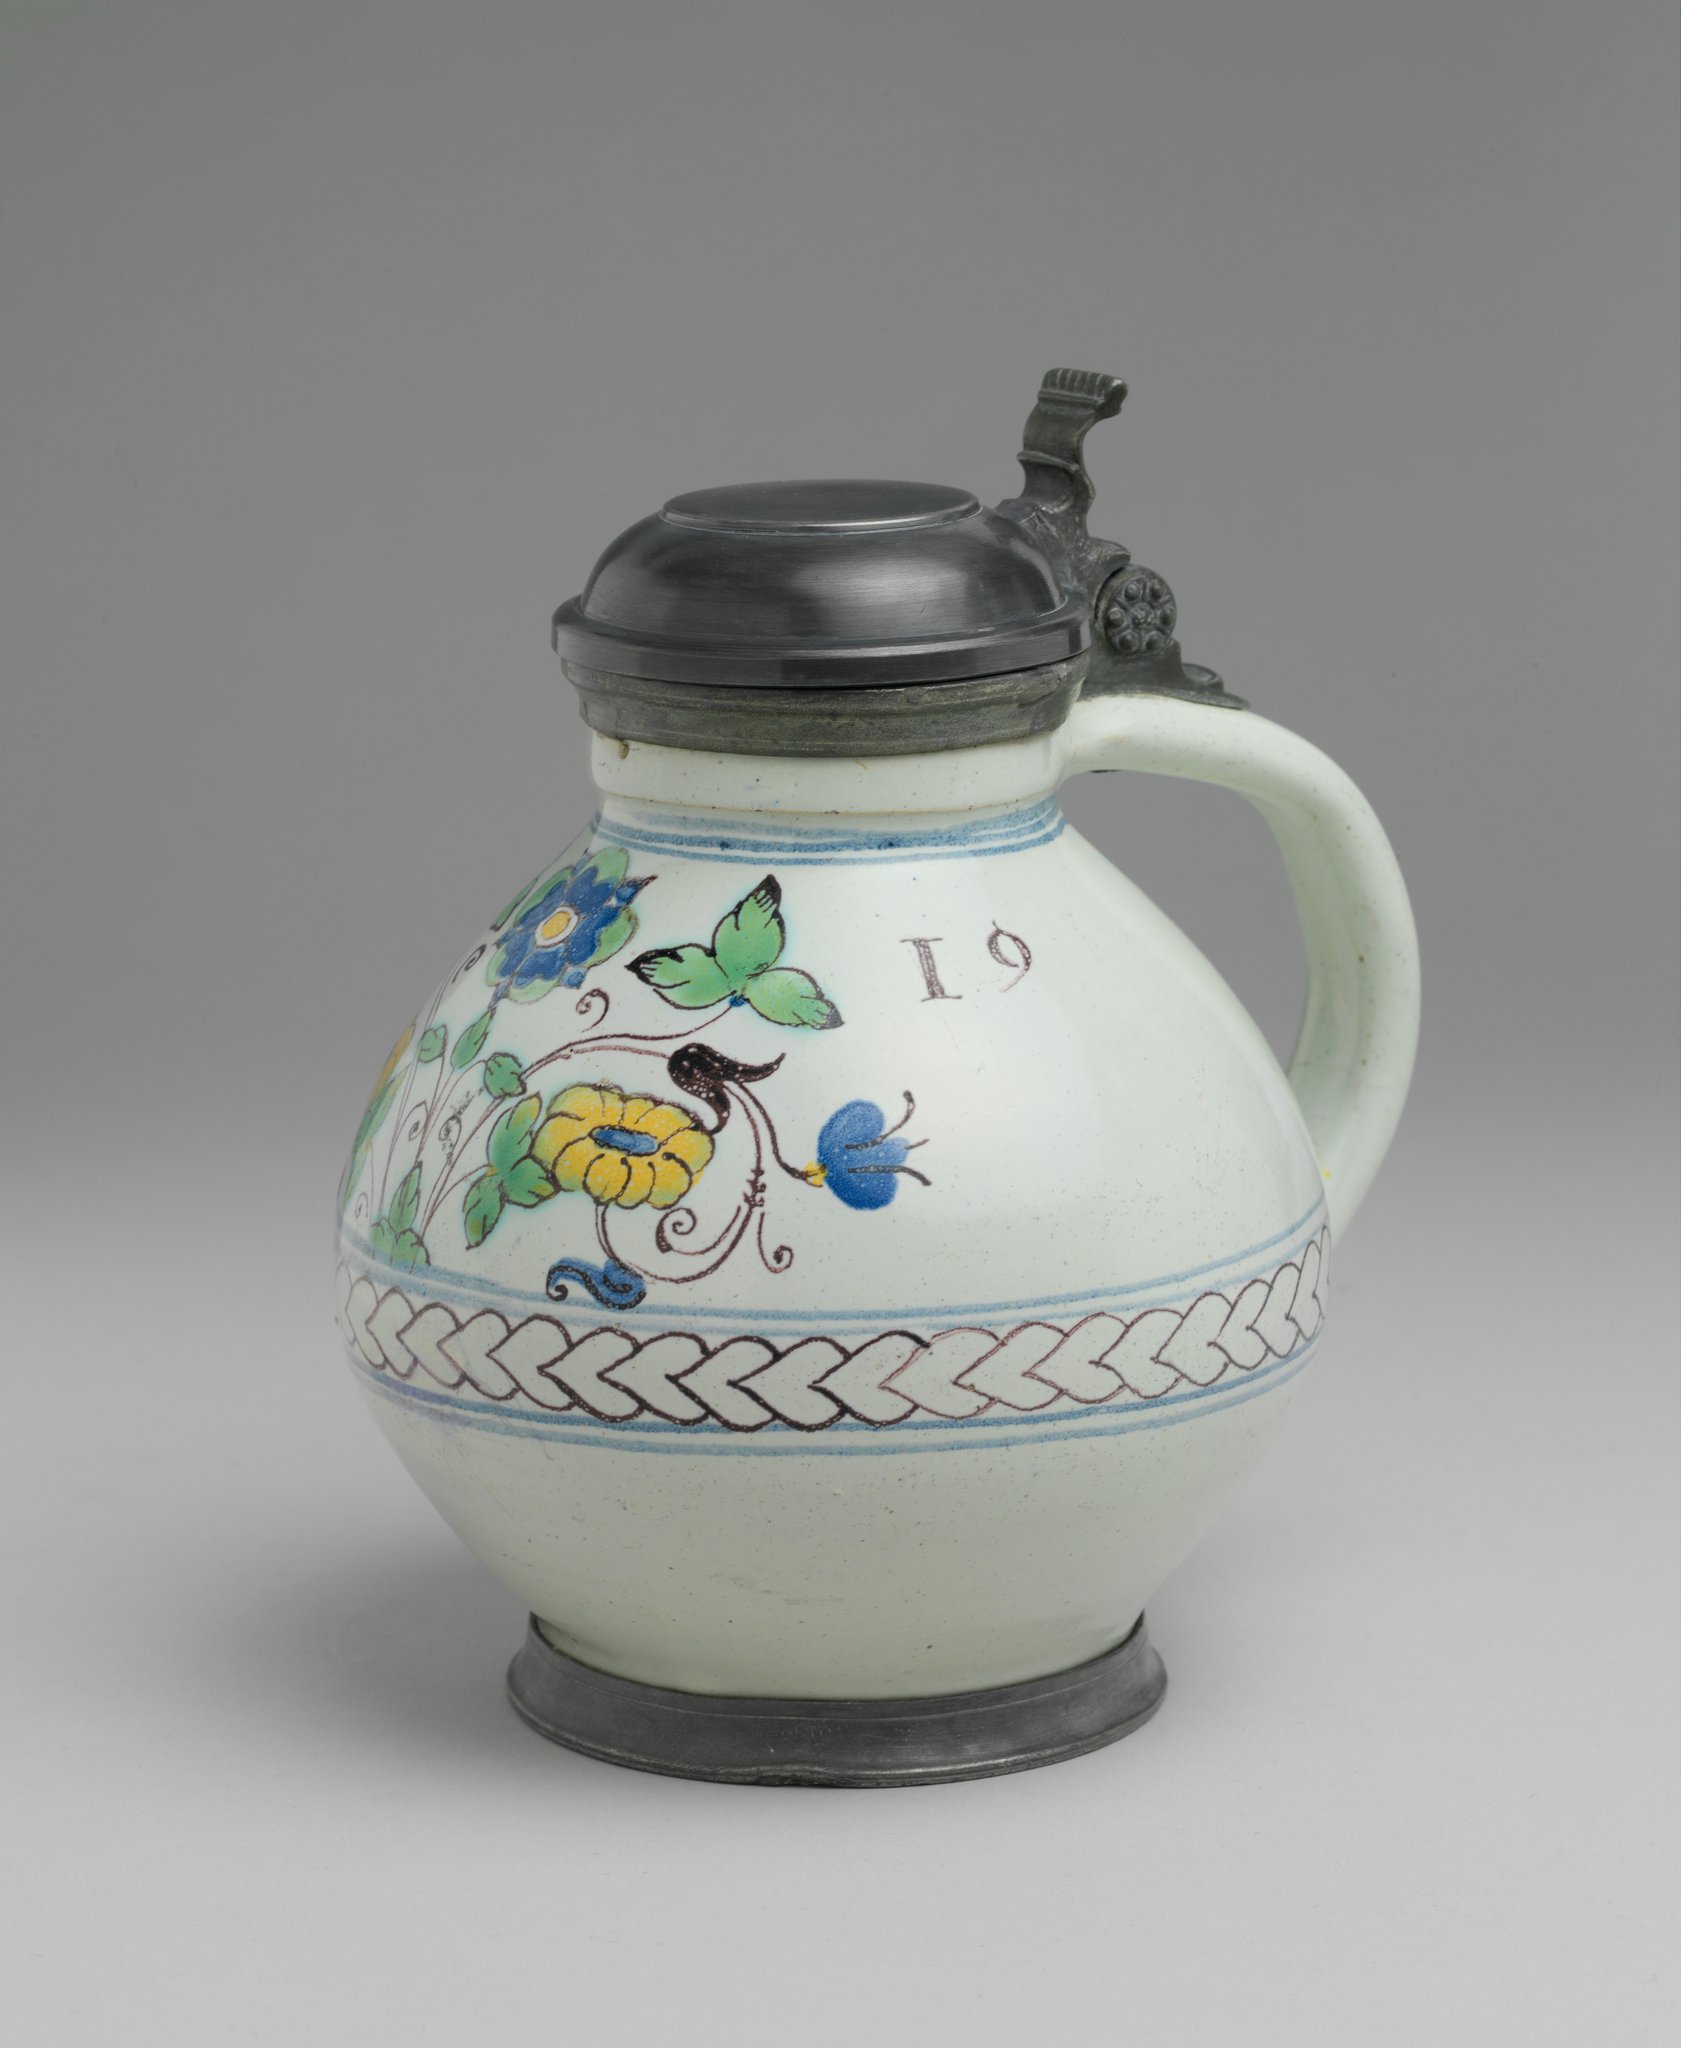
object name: jug with cover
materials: earthenware, pewter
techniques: glazing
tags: flowers